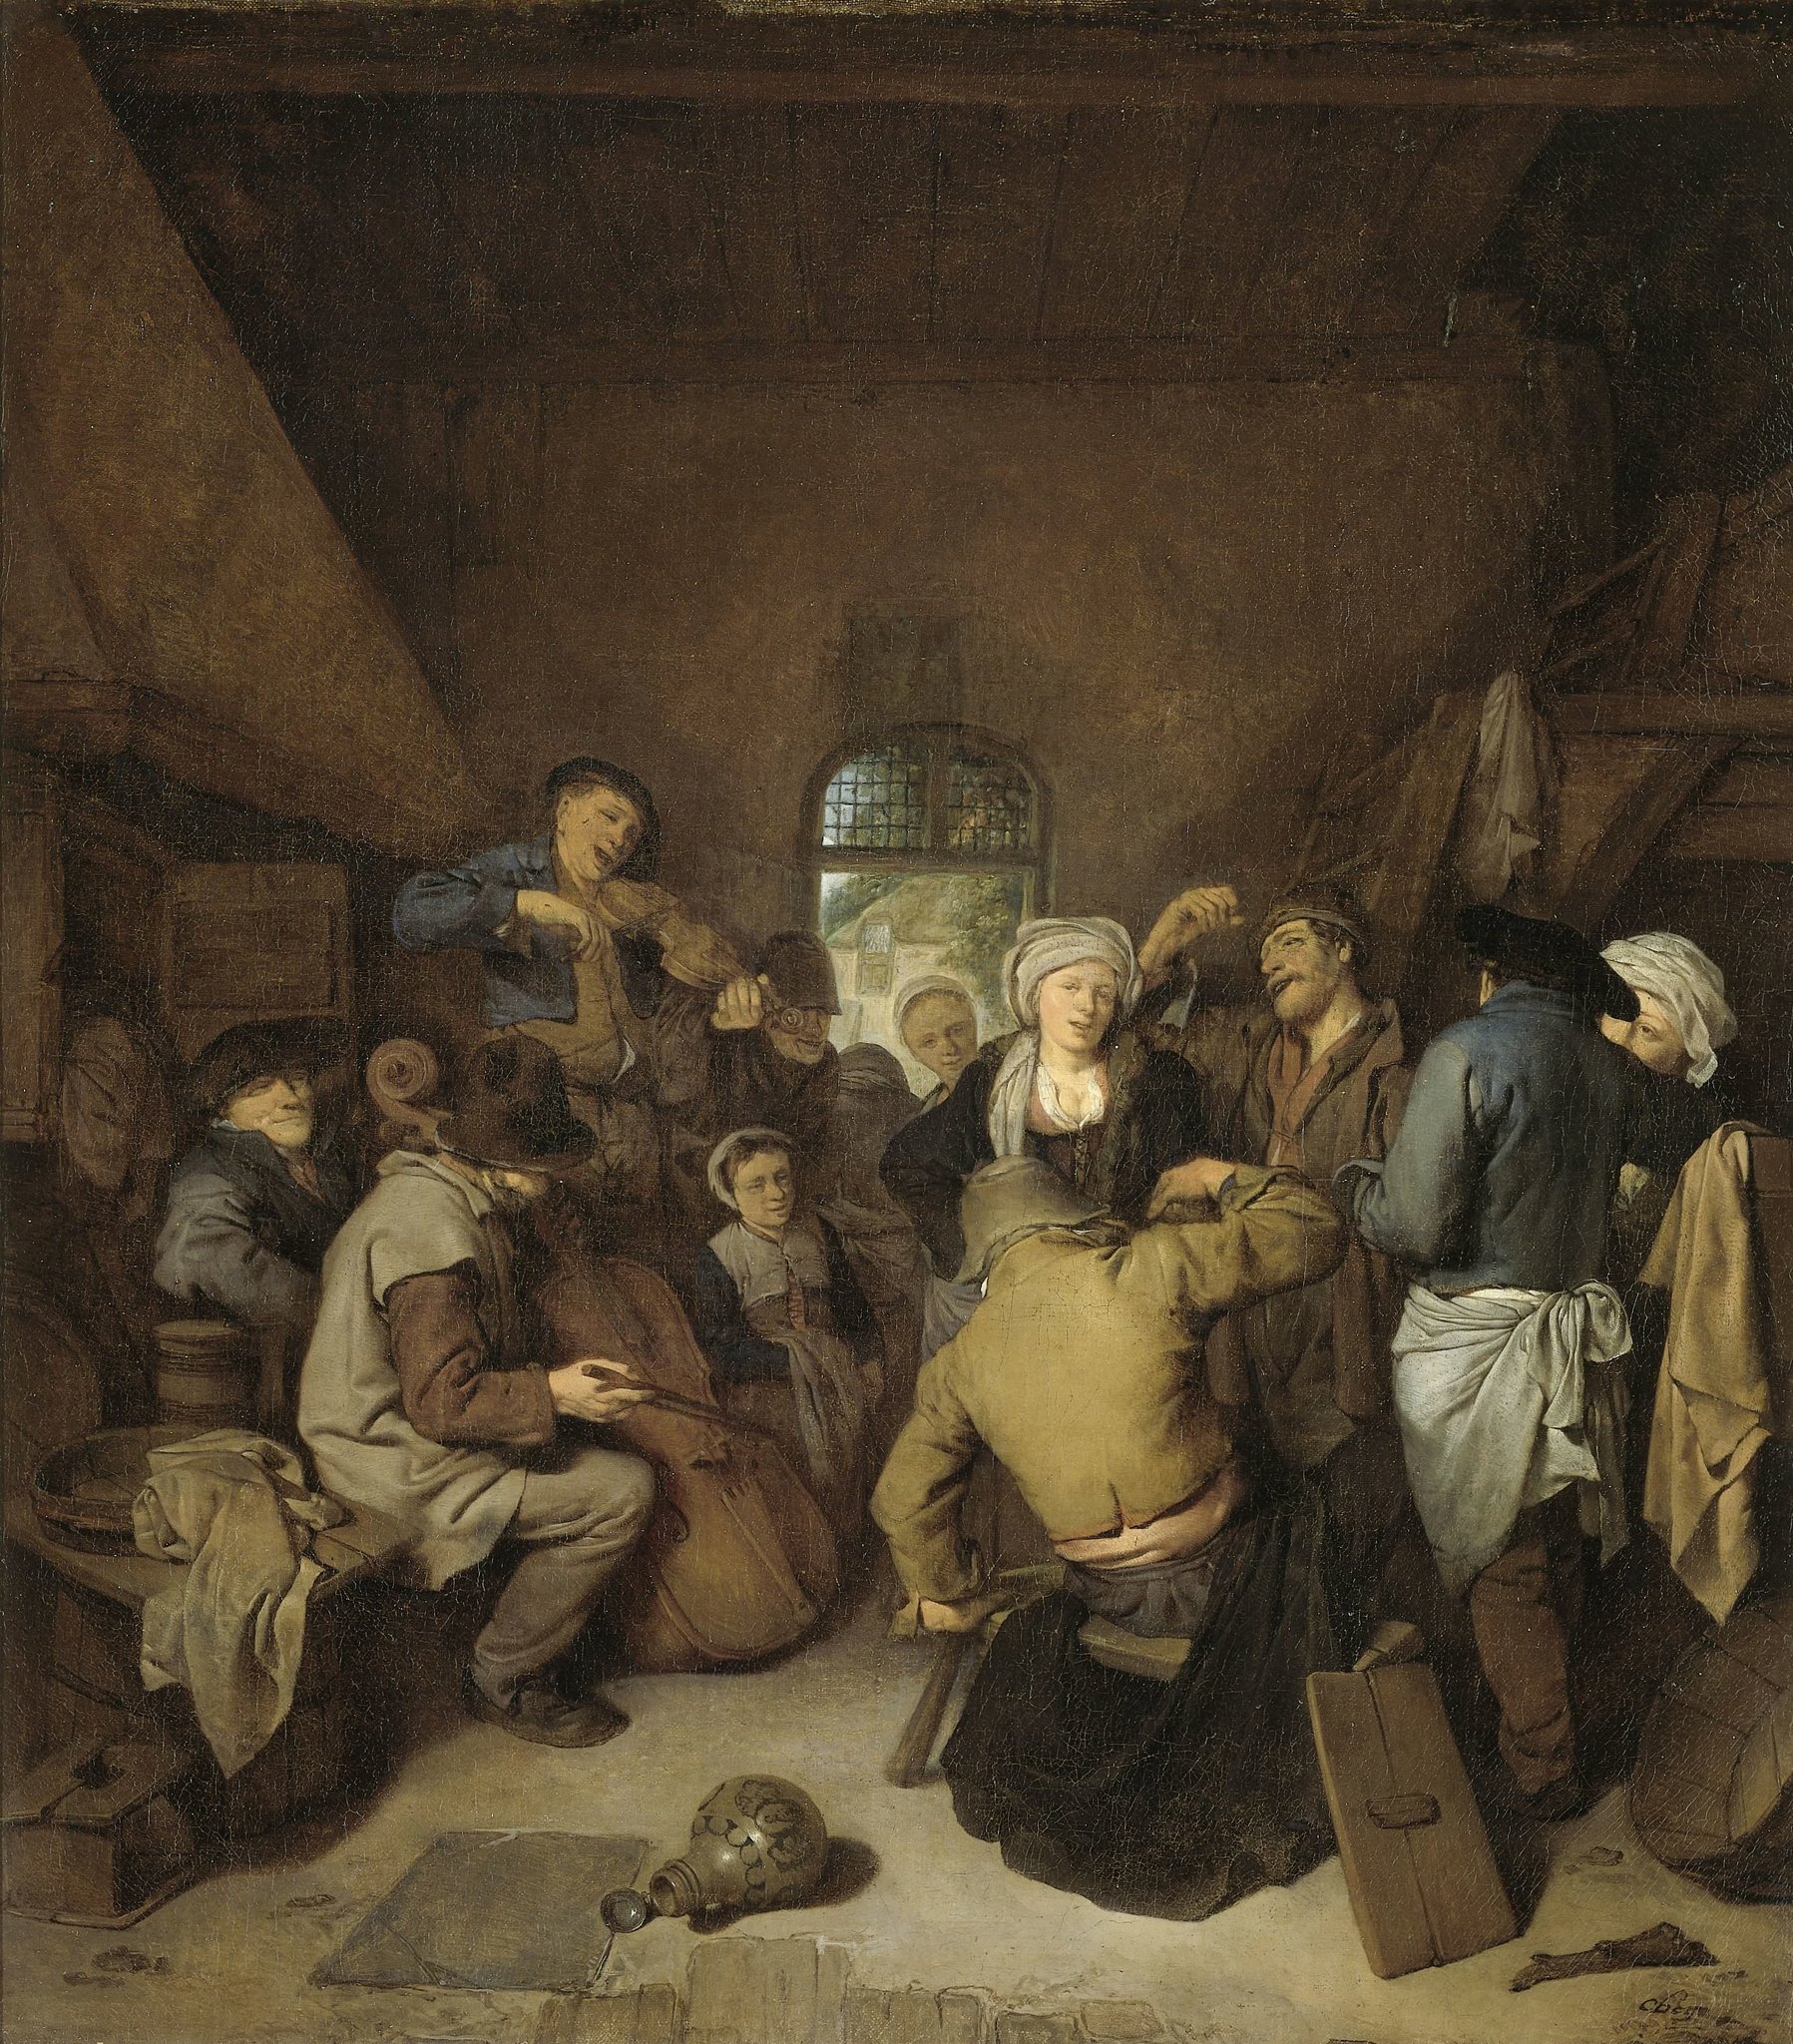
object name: painting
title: Peasants making Music and Dancing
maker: cornelis pietersz. bega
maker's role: draughtsman, painter, print maker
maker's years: 1631-1664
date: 1650-1664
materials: canvas, oil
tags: inn, coffee-house, public house, etc., folk dancing (men and women together), more than one musician with instrument, private festivities, merry company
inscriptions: signature: ‘c bega’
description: Interieur van een herberg met boeren die zingen, dansen en muziekmaken. Links muzikanten met een cello en viool.